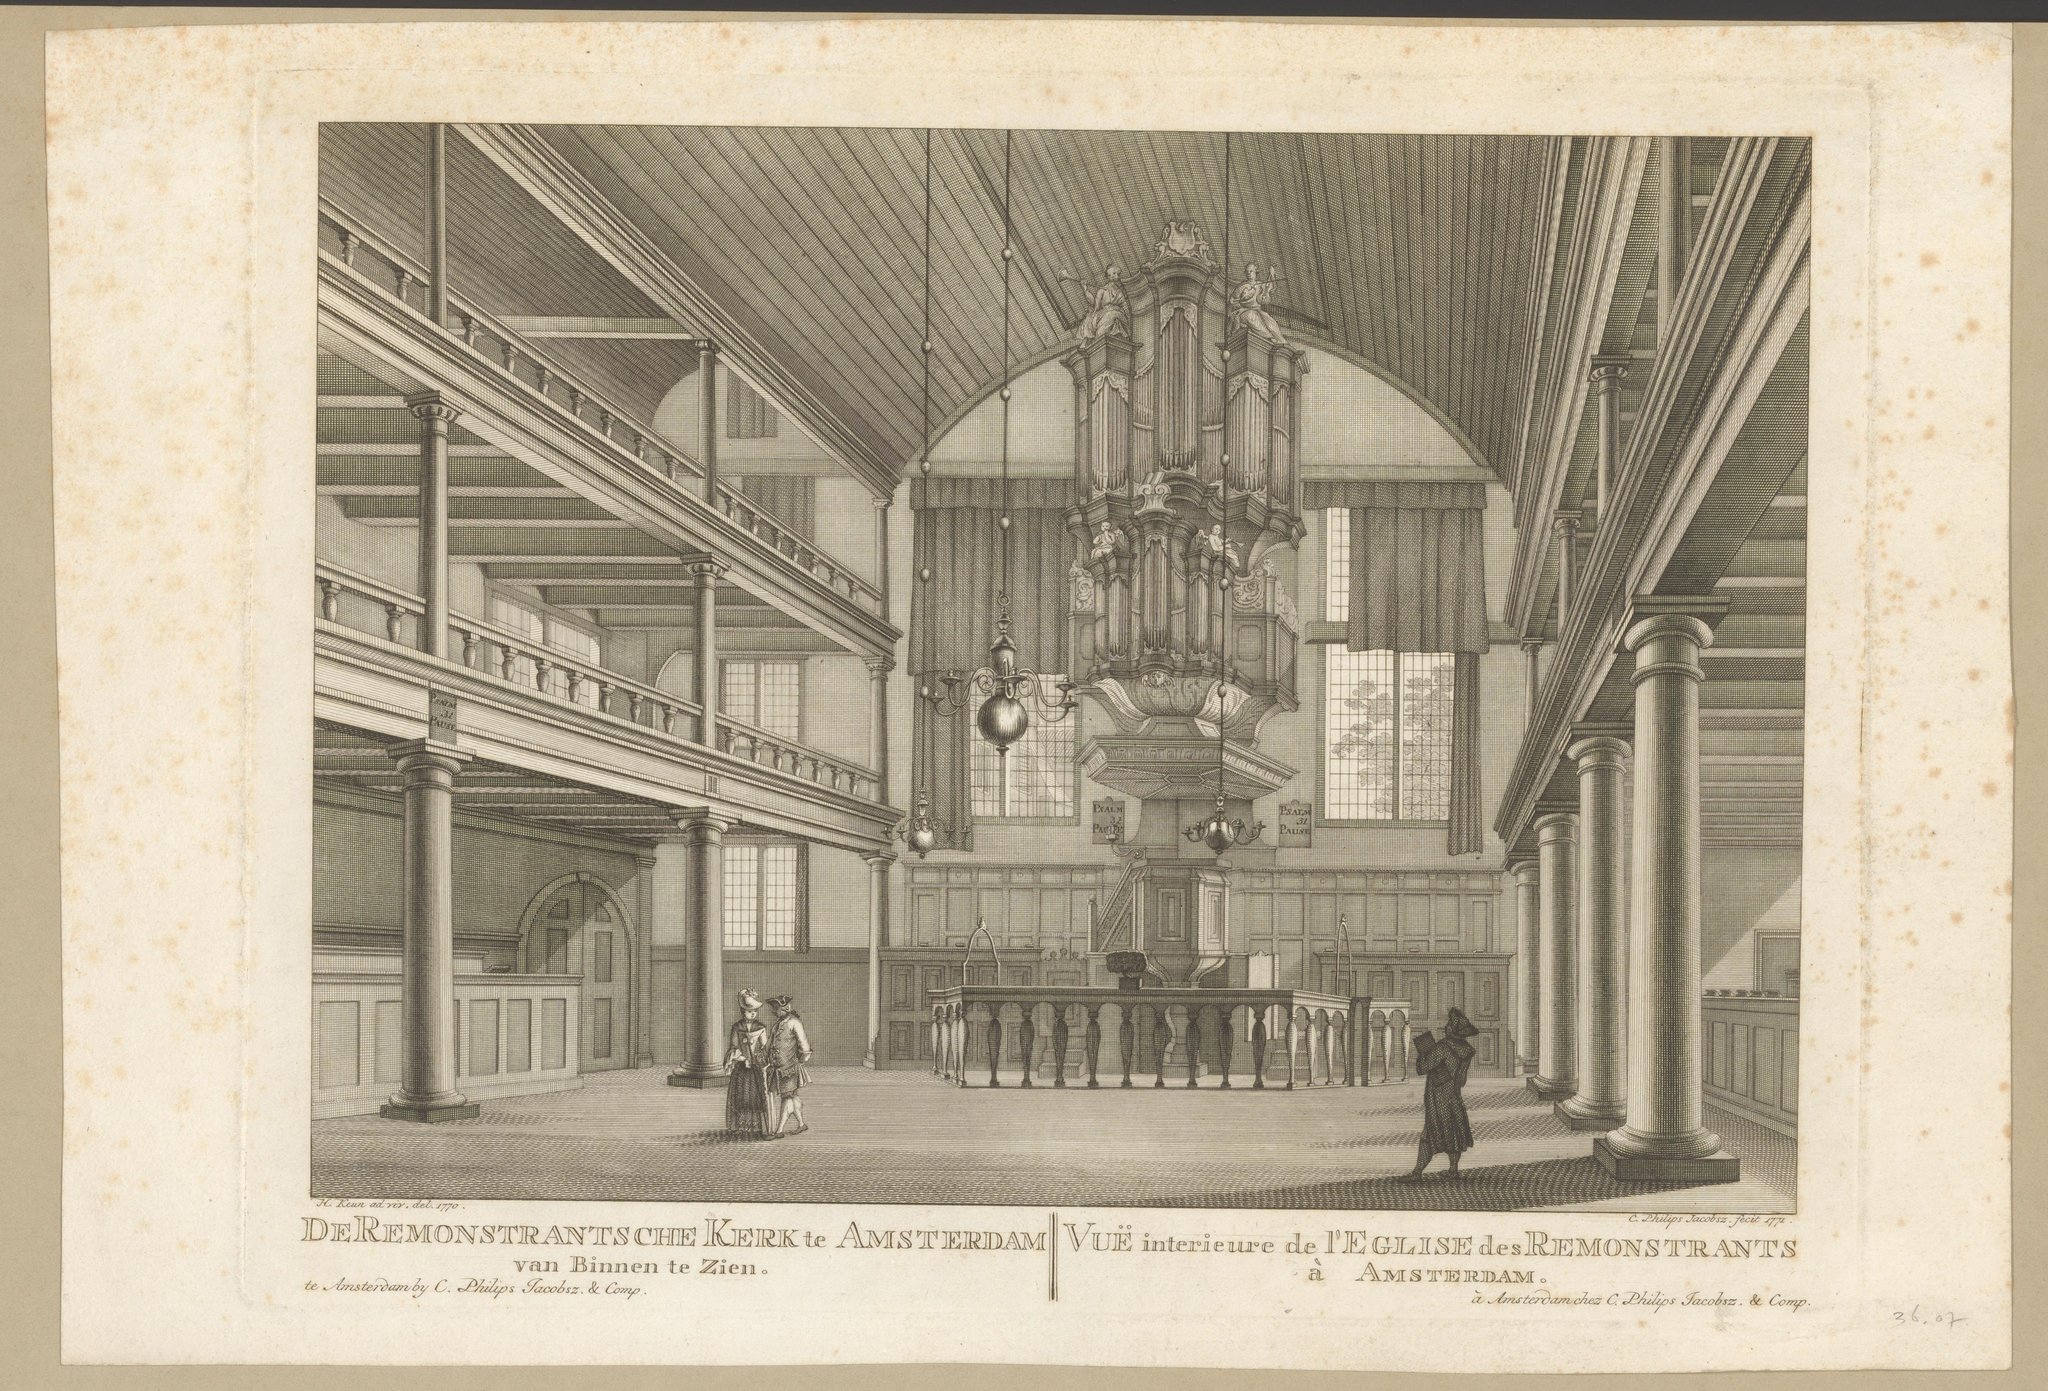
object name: print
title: Interieur van de Remonstrantse Kerk te Amsterdam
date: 1771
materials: paper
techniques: engraving, etching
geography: amsterdam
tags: interior of church, amsterdam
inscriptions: collector's mark: Lugt 1641b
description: Onderwerpsrubriek binnen de Atlas Amsterdam: Kerkwezen: Remonstrantse Gemeente.